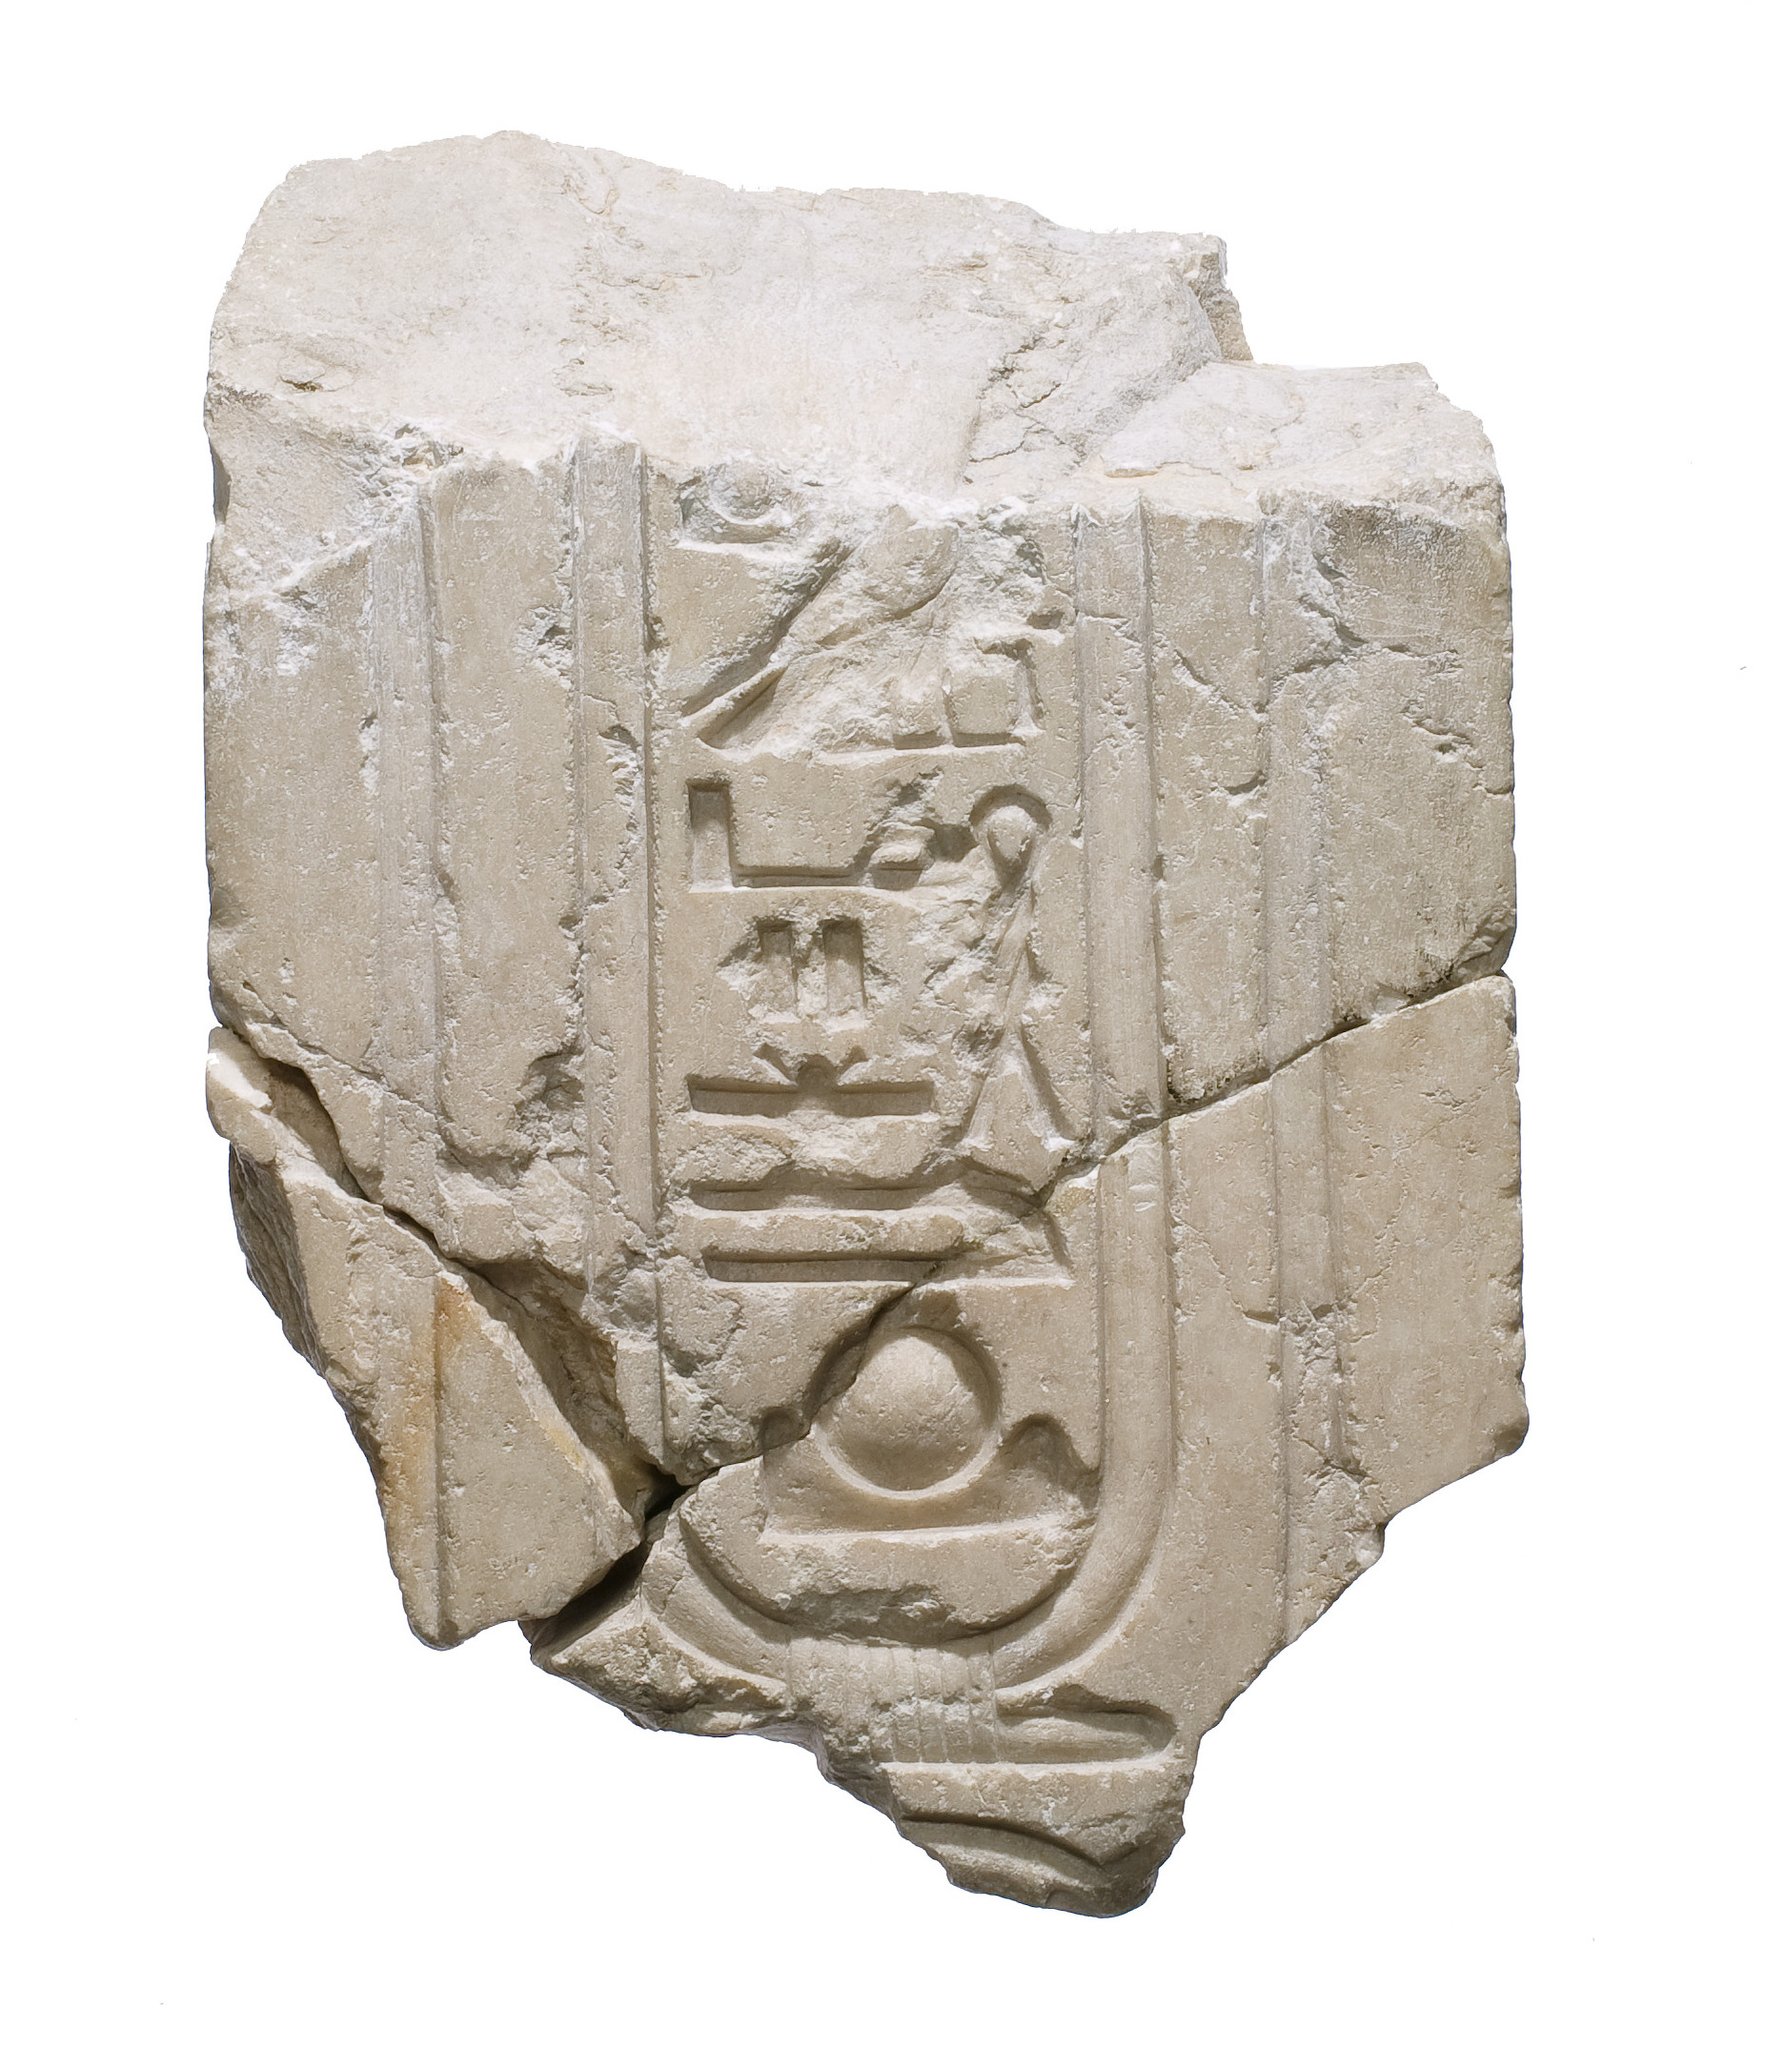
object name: back pillar of torso, with aten cartouch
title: Back pillar of Torso with Aten cartouches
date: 1353-1336 BCE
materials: limestone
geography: egypt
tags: cartouches,hieroglyphs